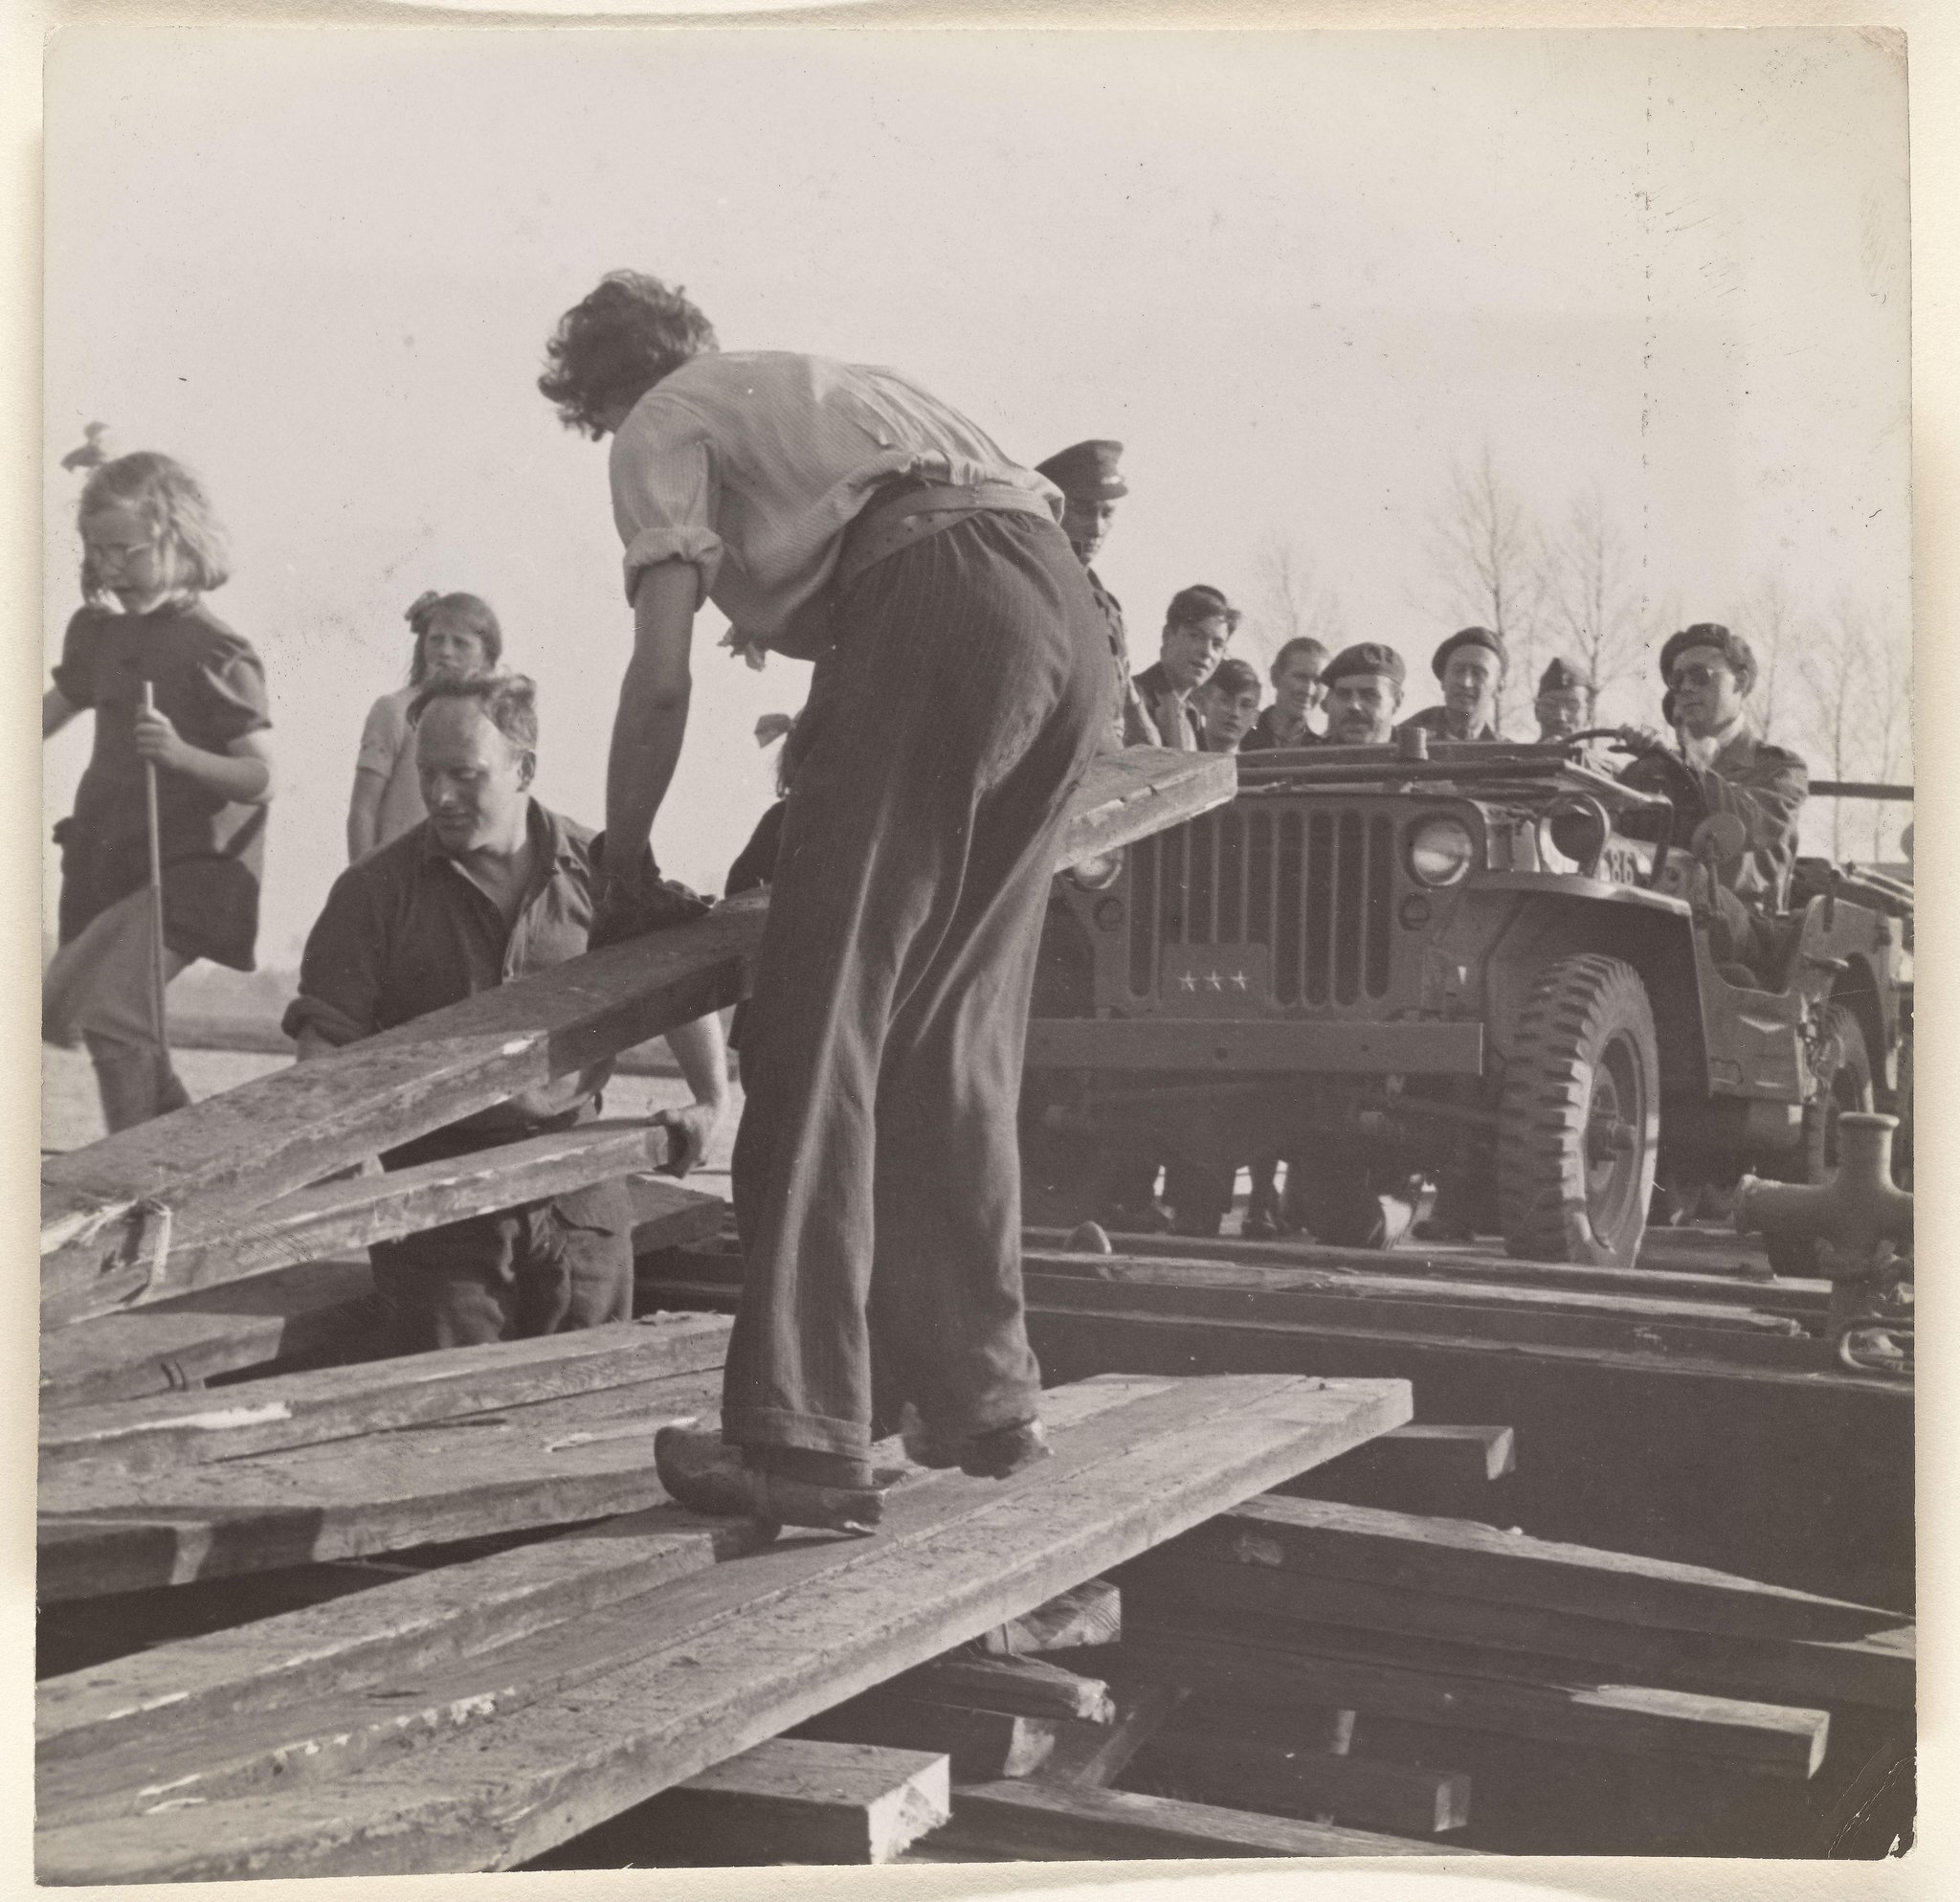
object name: photograph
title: Prins Bernhard op de veerboot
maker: louis woudhuysen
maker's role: fotograaf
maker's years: 1912-1985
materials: photographic support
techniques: photography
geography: zwolle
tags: utrecht, bernhard (prins der nederlanden)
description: Prins Bernhard op de veerboot over de Vecht bij Zwolle in een jeep. Op de voorgrond worden door twee mannen planken verplaatst.